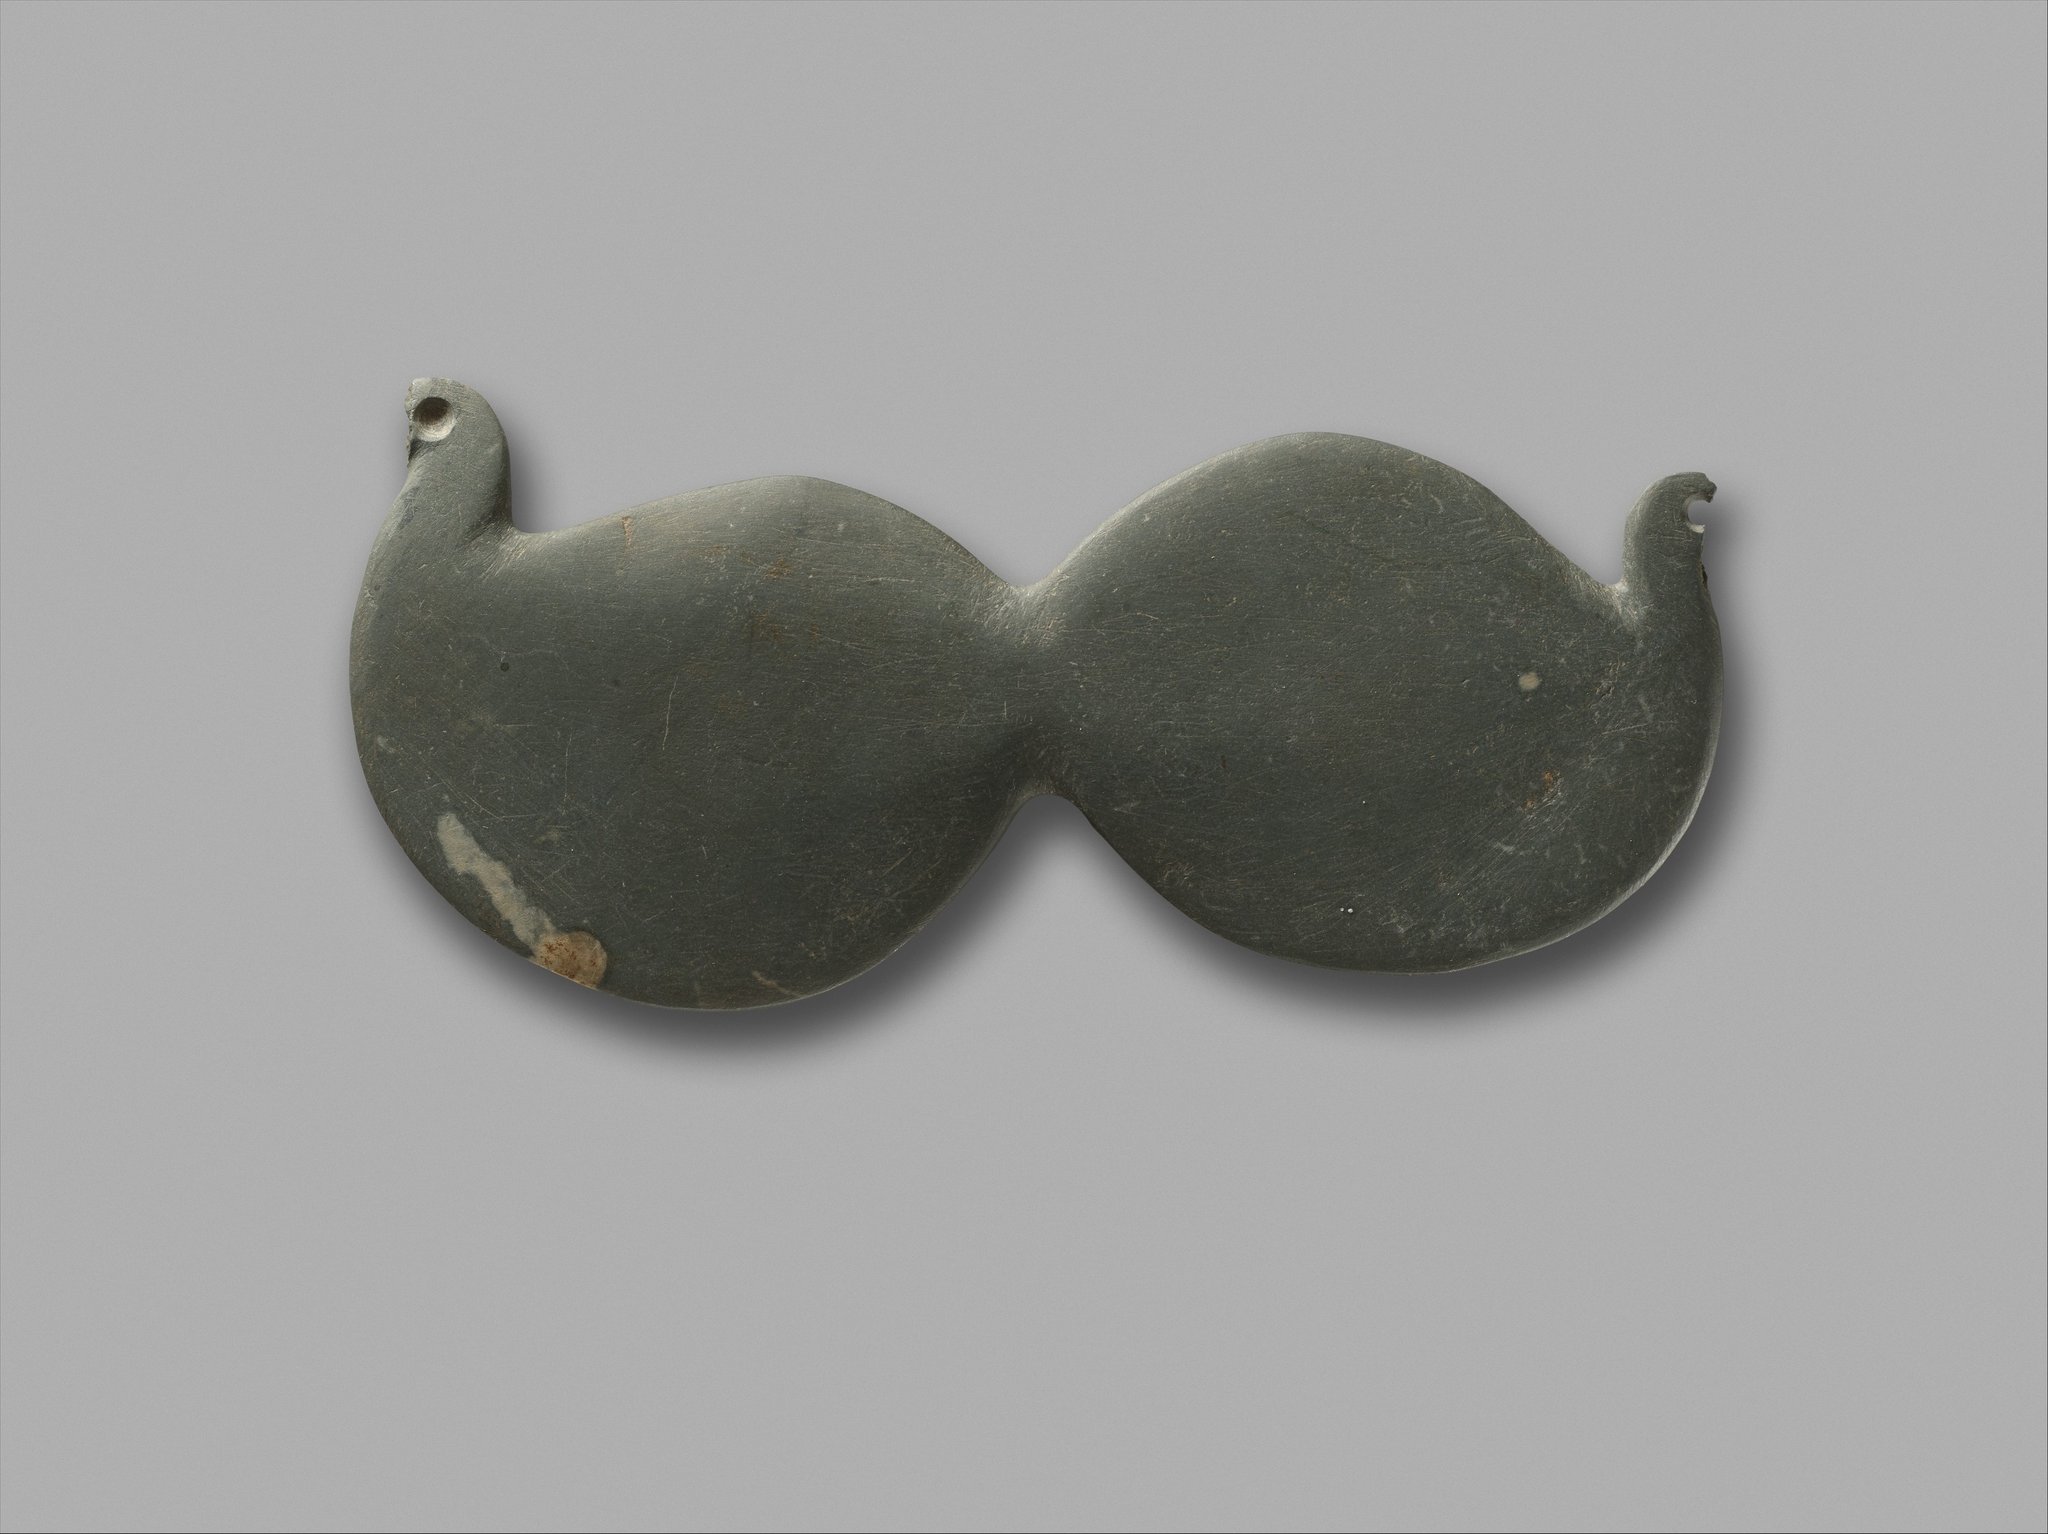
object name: palette, double bird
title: Palette with two birds attached at their tails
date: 3650-3500 BCE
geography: egypt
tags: birds